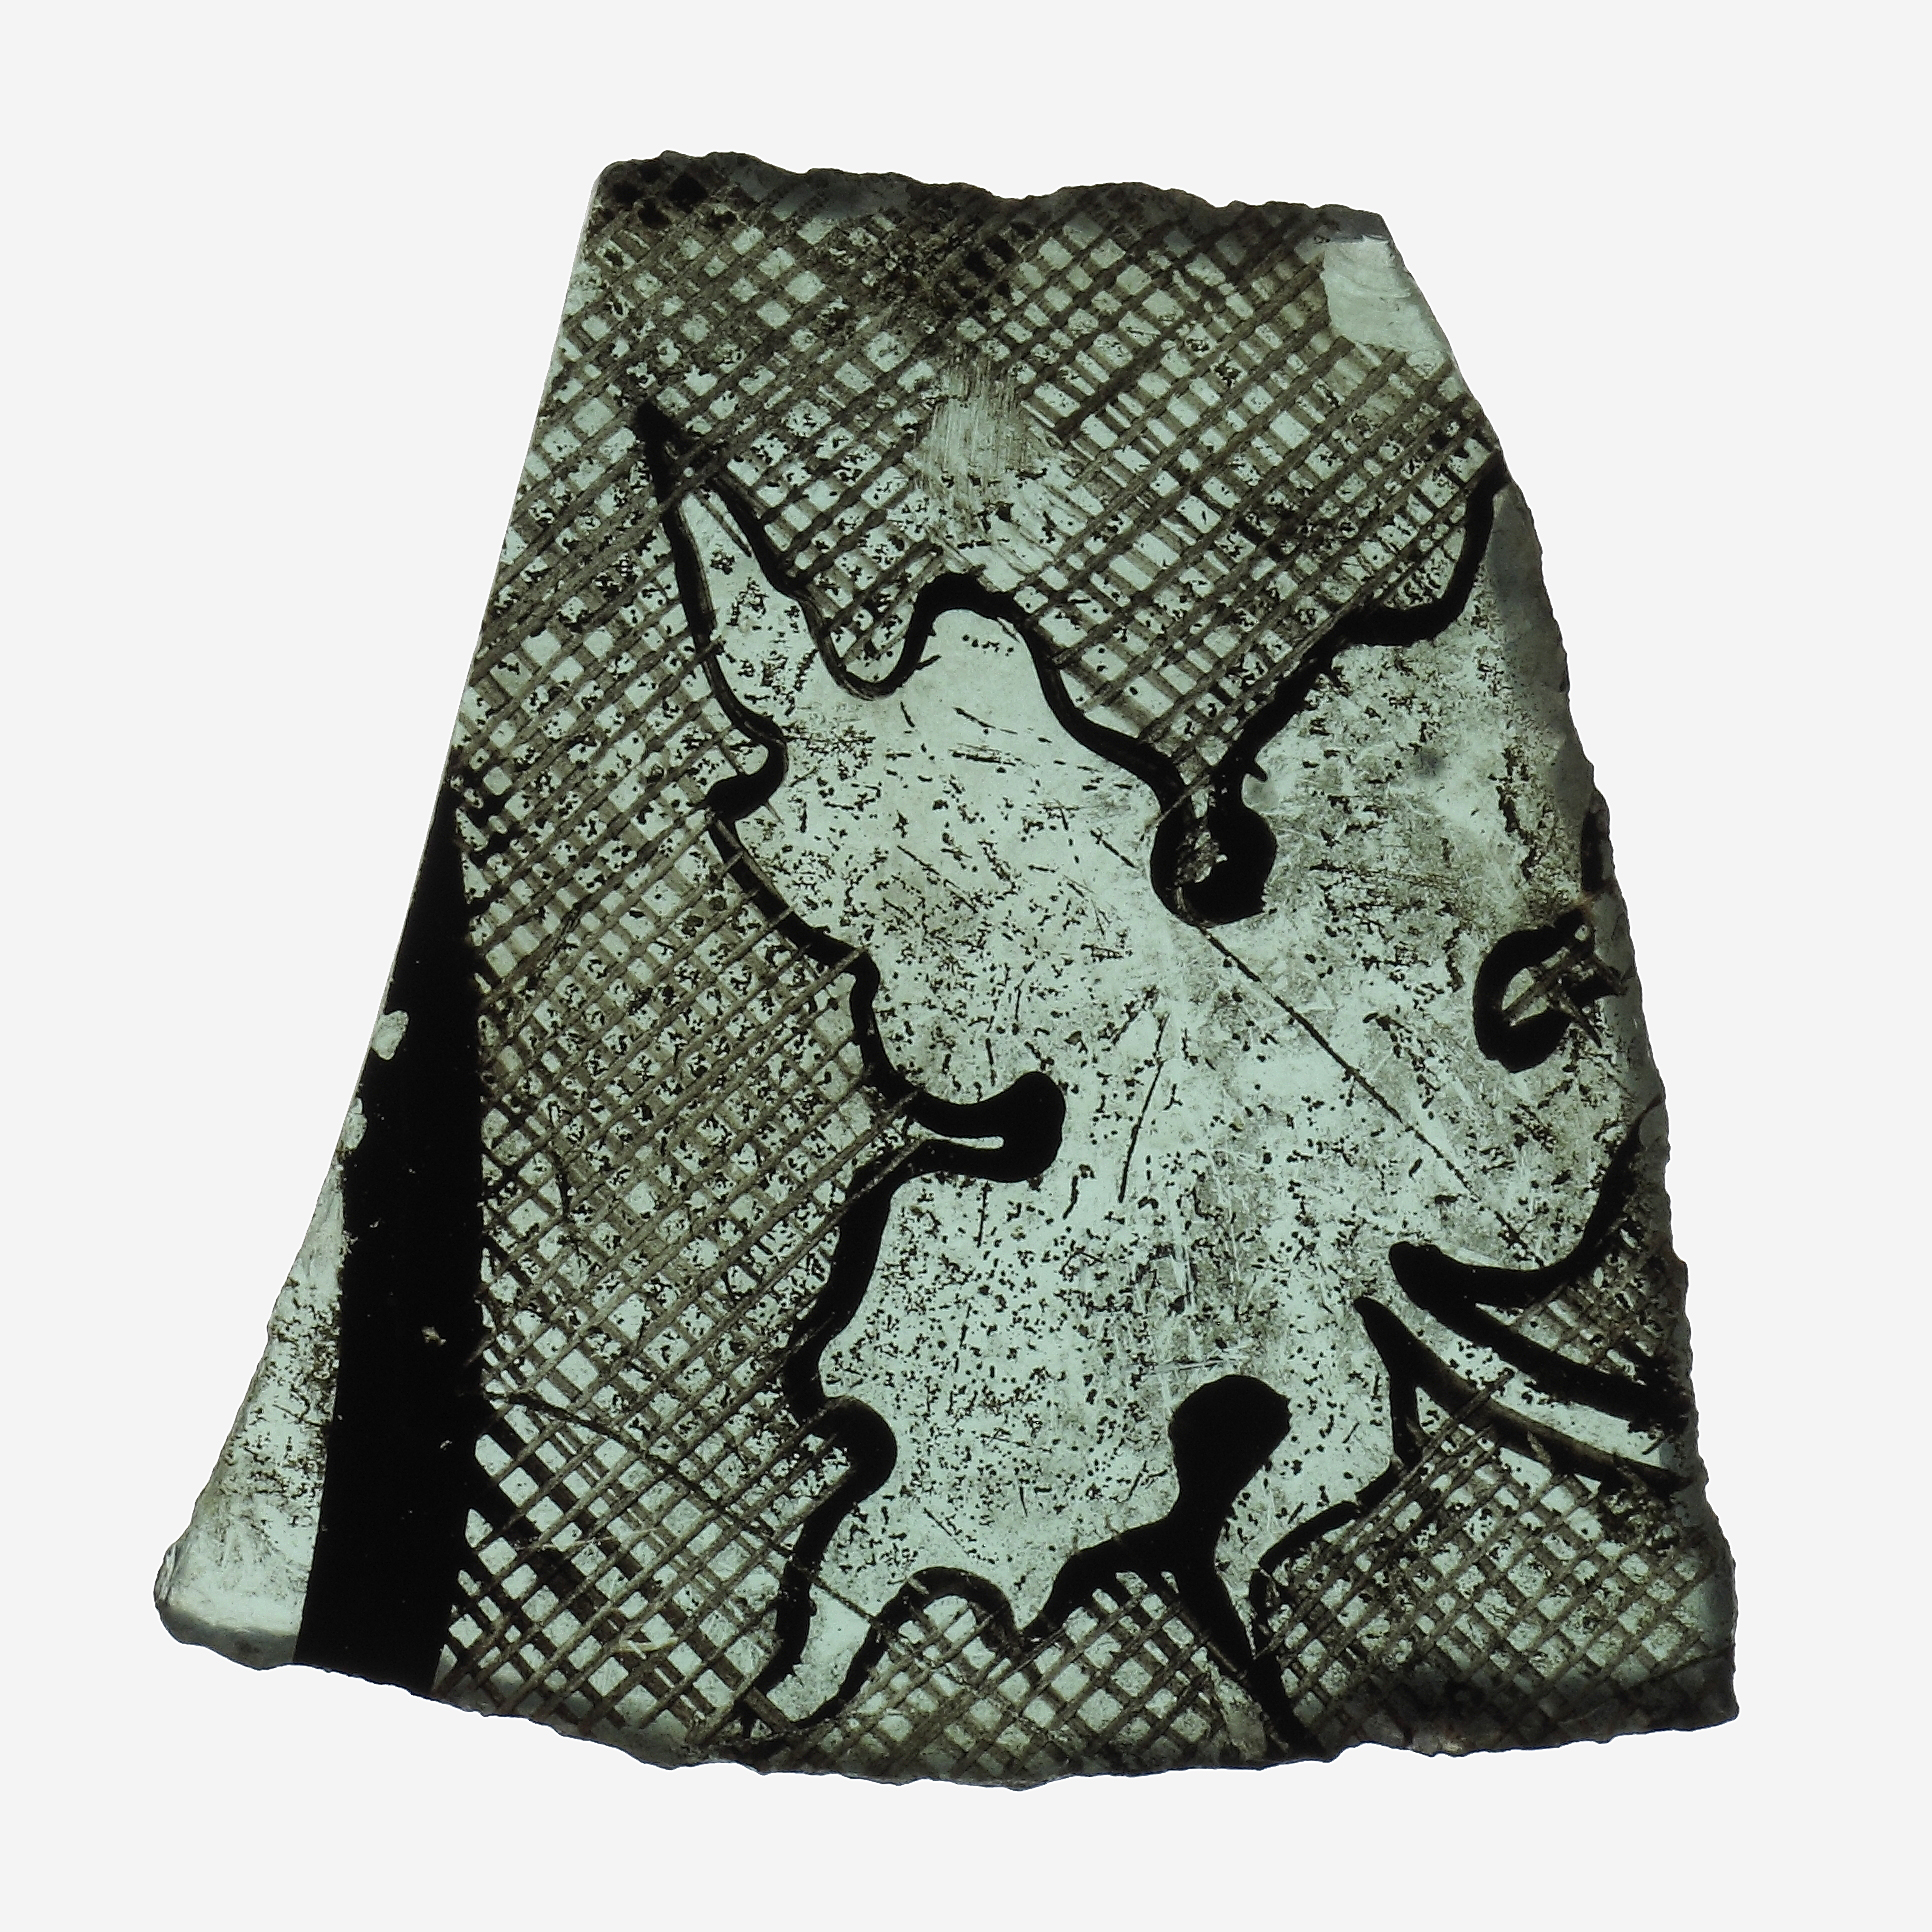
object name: fragment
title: Glass Fragment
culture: british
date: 1301-1400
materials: glass